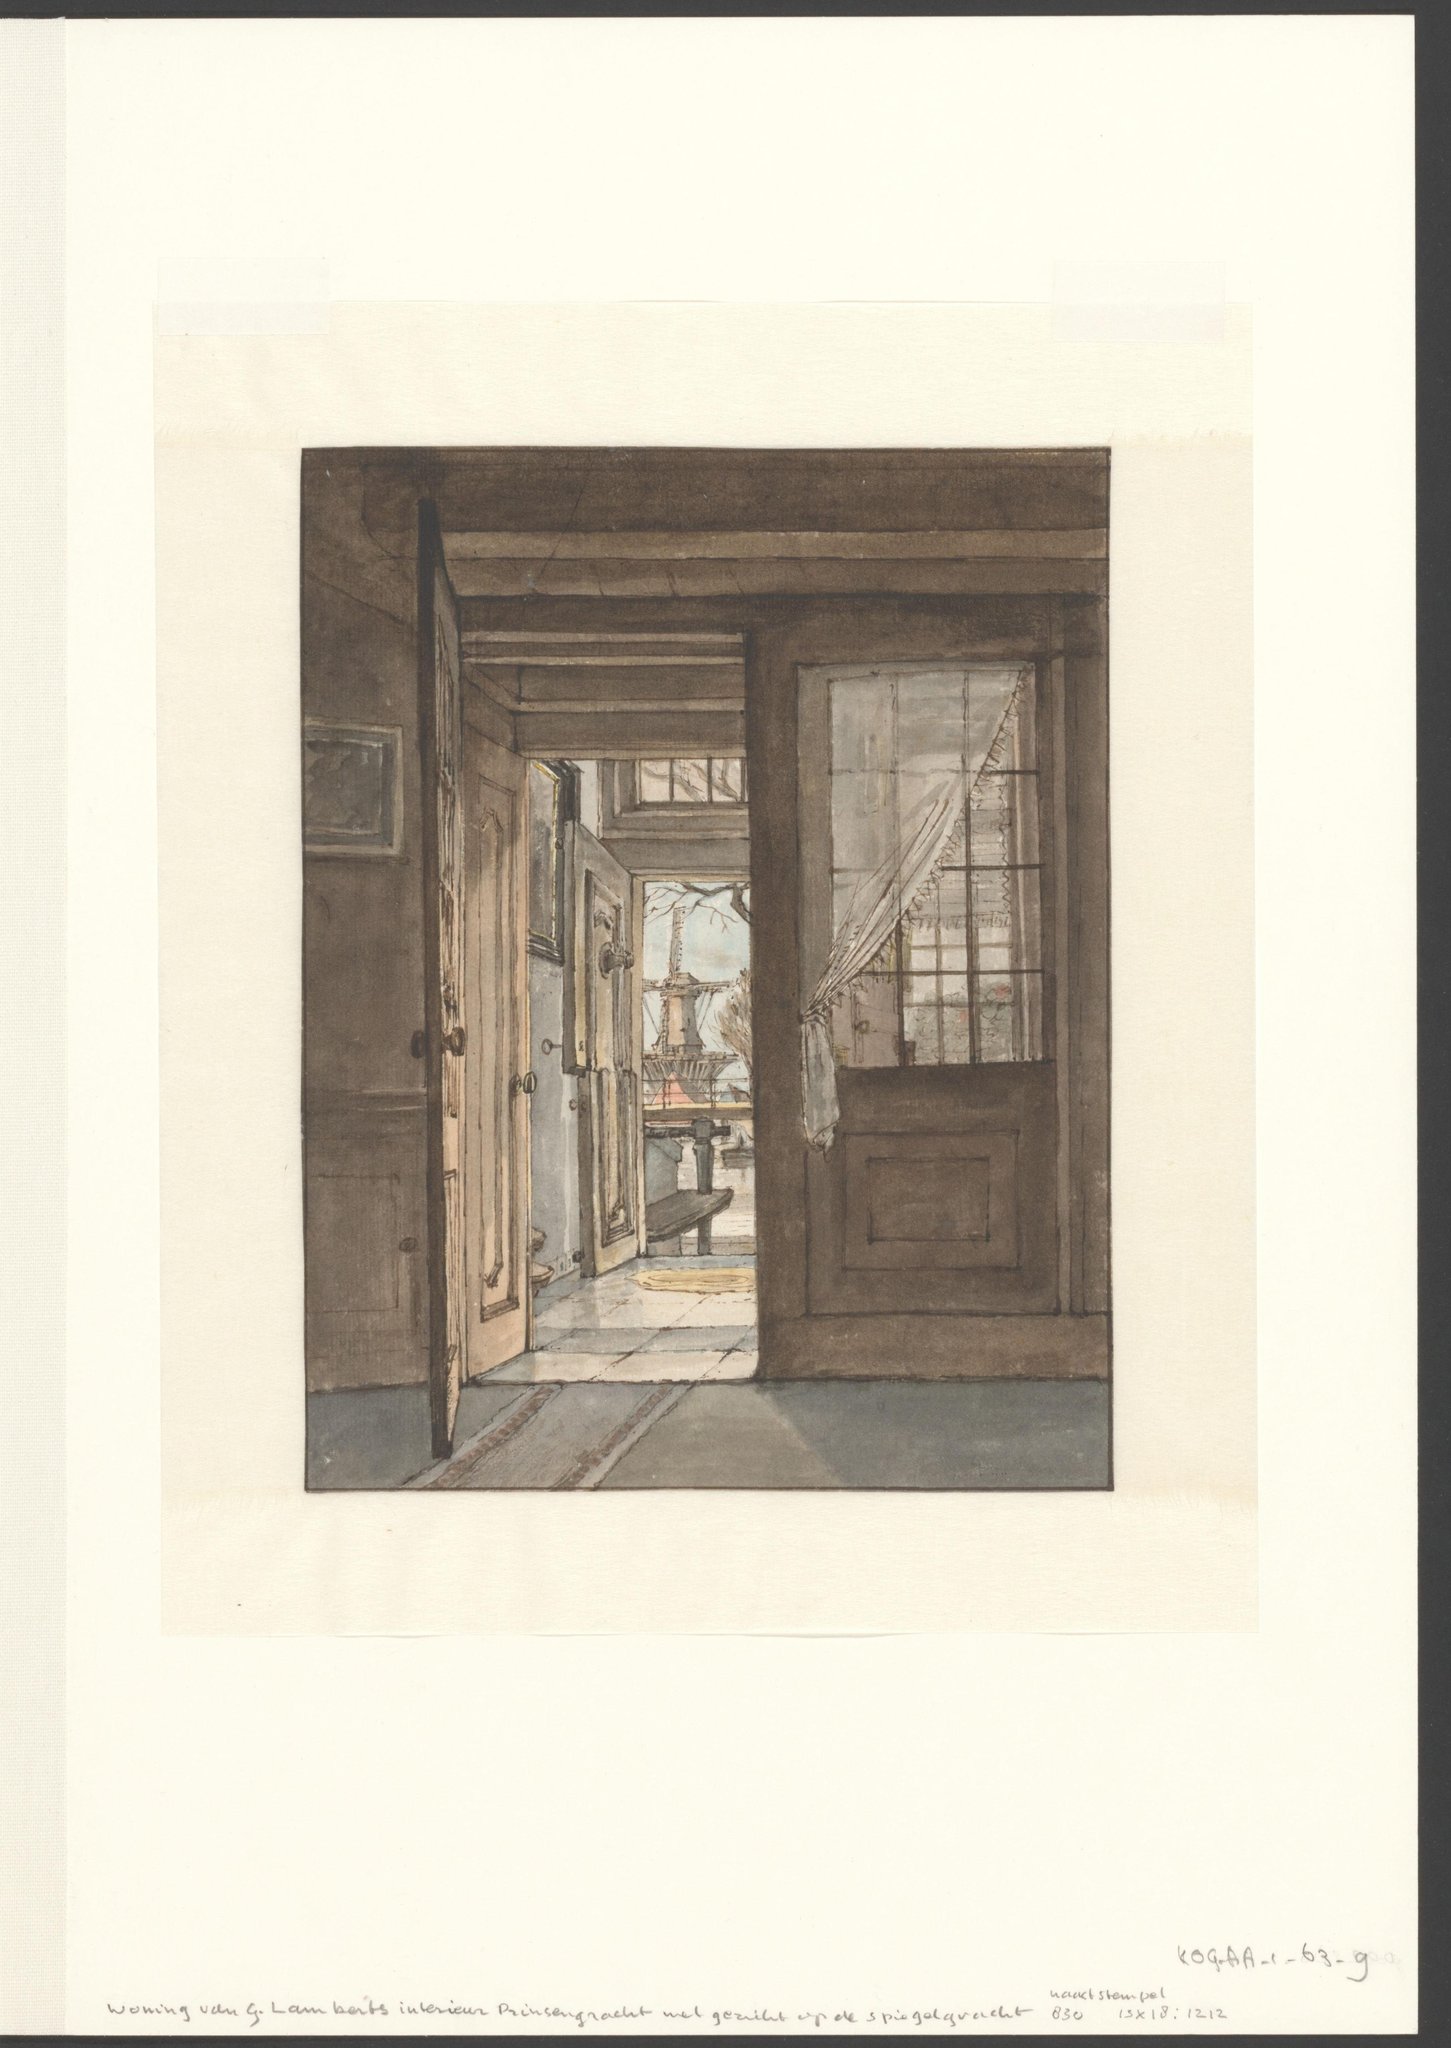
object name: drawing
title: Interieur van de woning van Gerrit Lamberts op de Prinsengracht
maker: gerrit lamberts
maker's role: bookseller, draughtsman, print maker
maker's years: 1776-1850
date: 1786-1850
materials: ink, paper, watercolor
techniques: brush, pen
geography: amsterdam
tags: city-view in general; 'veduta', open door, windmill in landscape, vestibule, hall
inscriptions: inscription: ‘XXXI / Gezicht uit Lamberts woning’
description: Onderwerpsrubriek binnen de Atlas Amsterdam: Binnenhuizen.